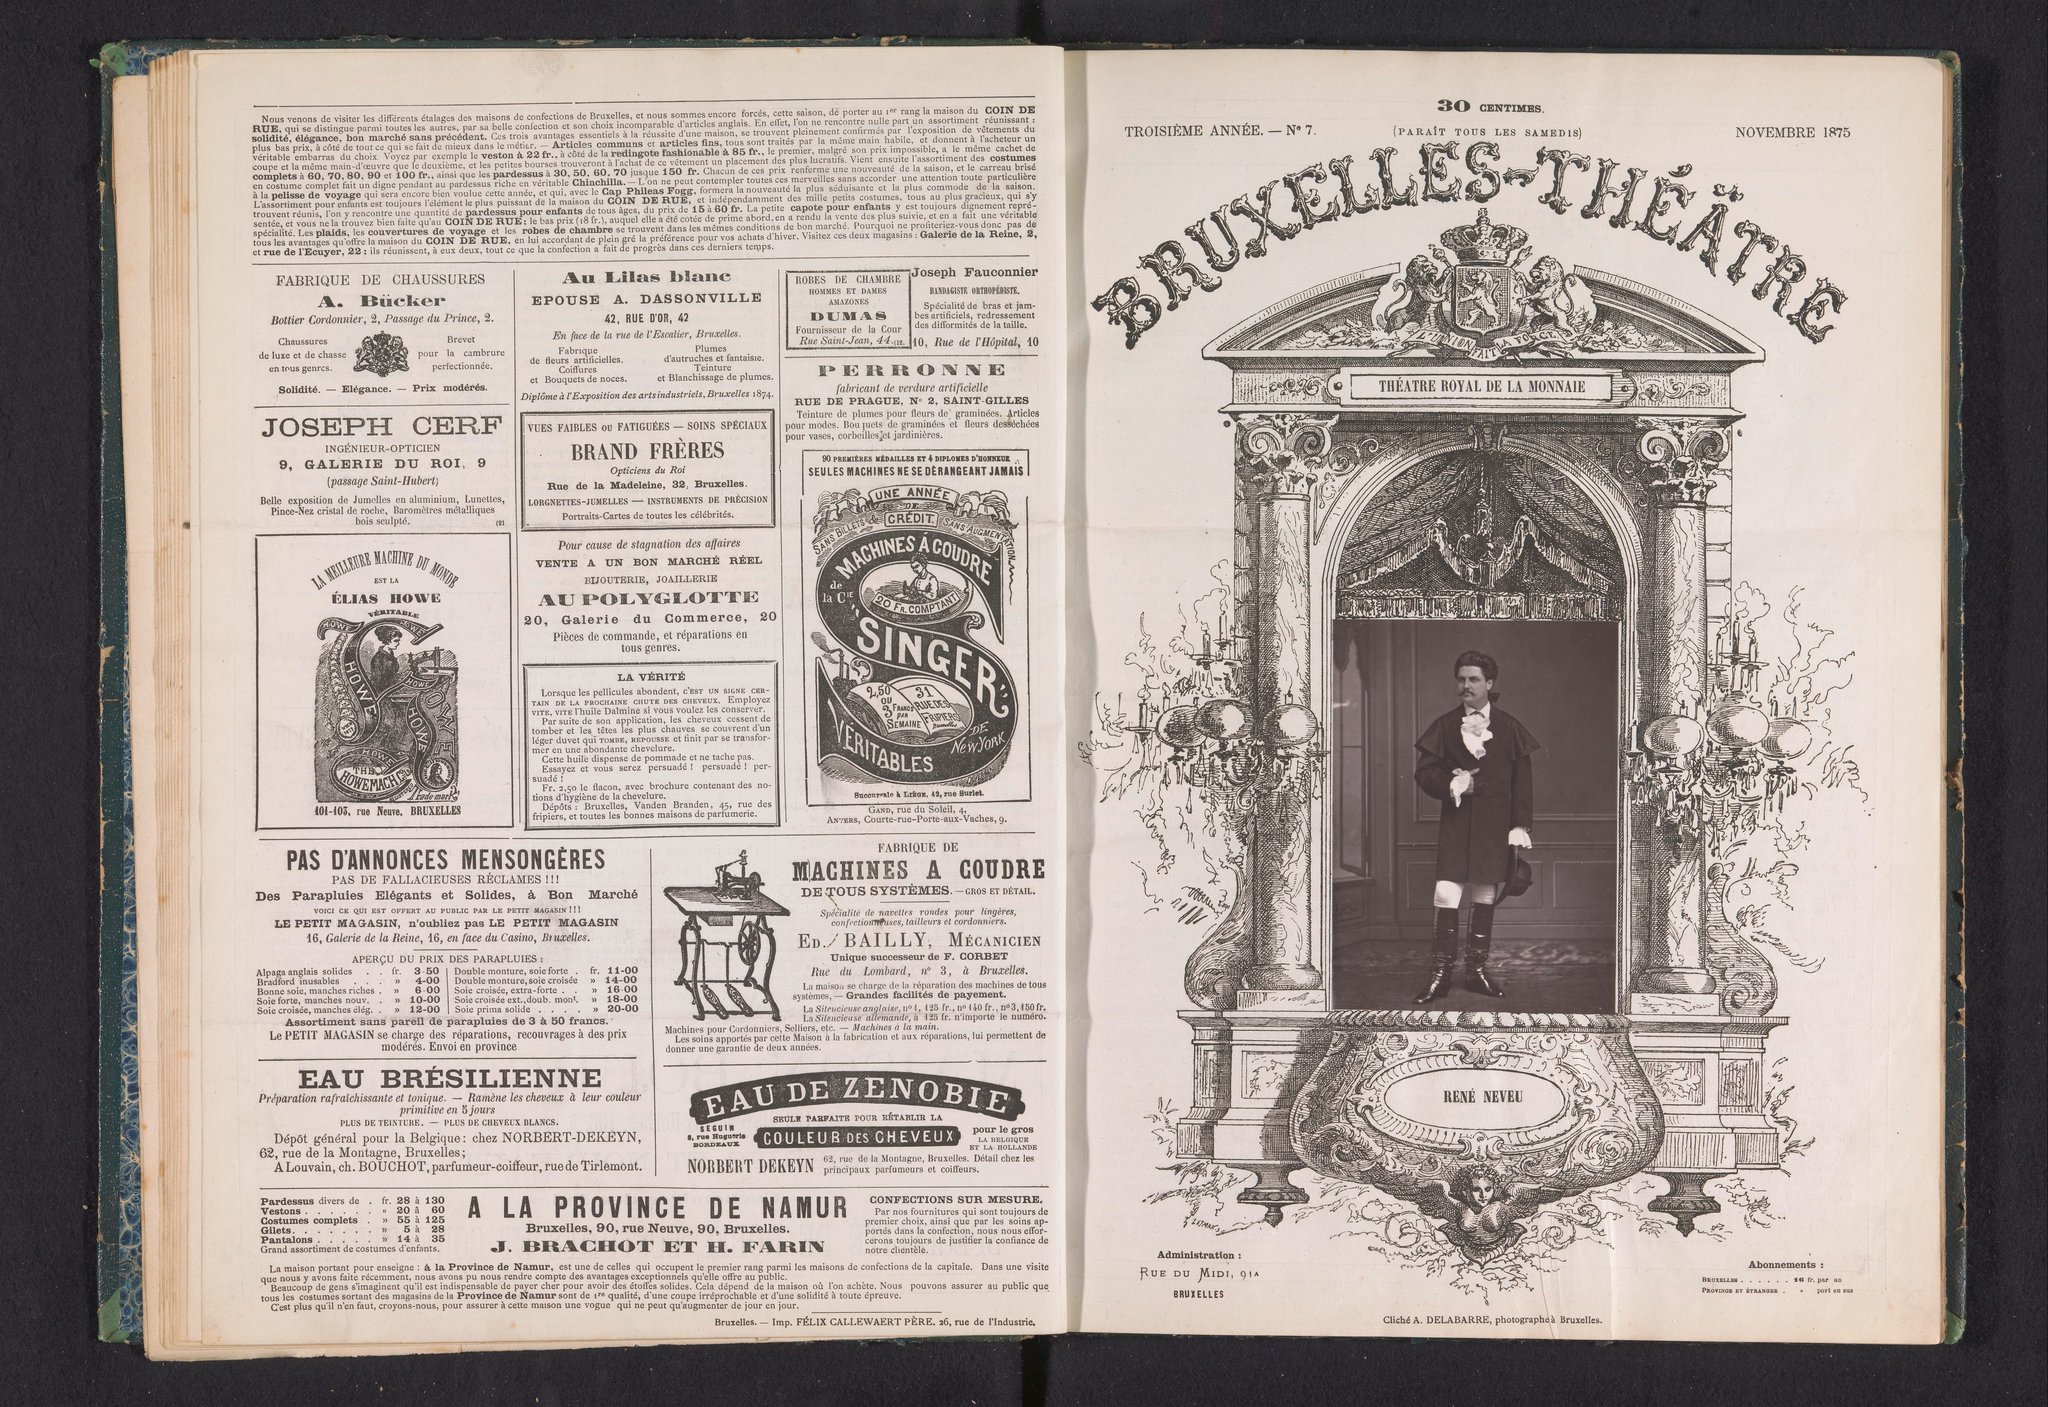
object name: page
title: René Neveu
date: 1870-1875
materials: paper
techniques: woodburytype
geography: brussels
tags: portrait of actor, actress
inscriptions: number: ‘No 7.’